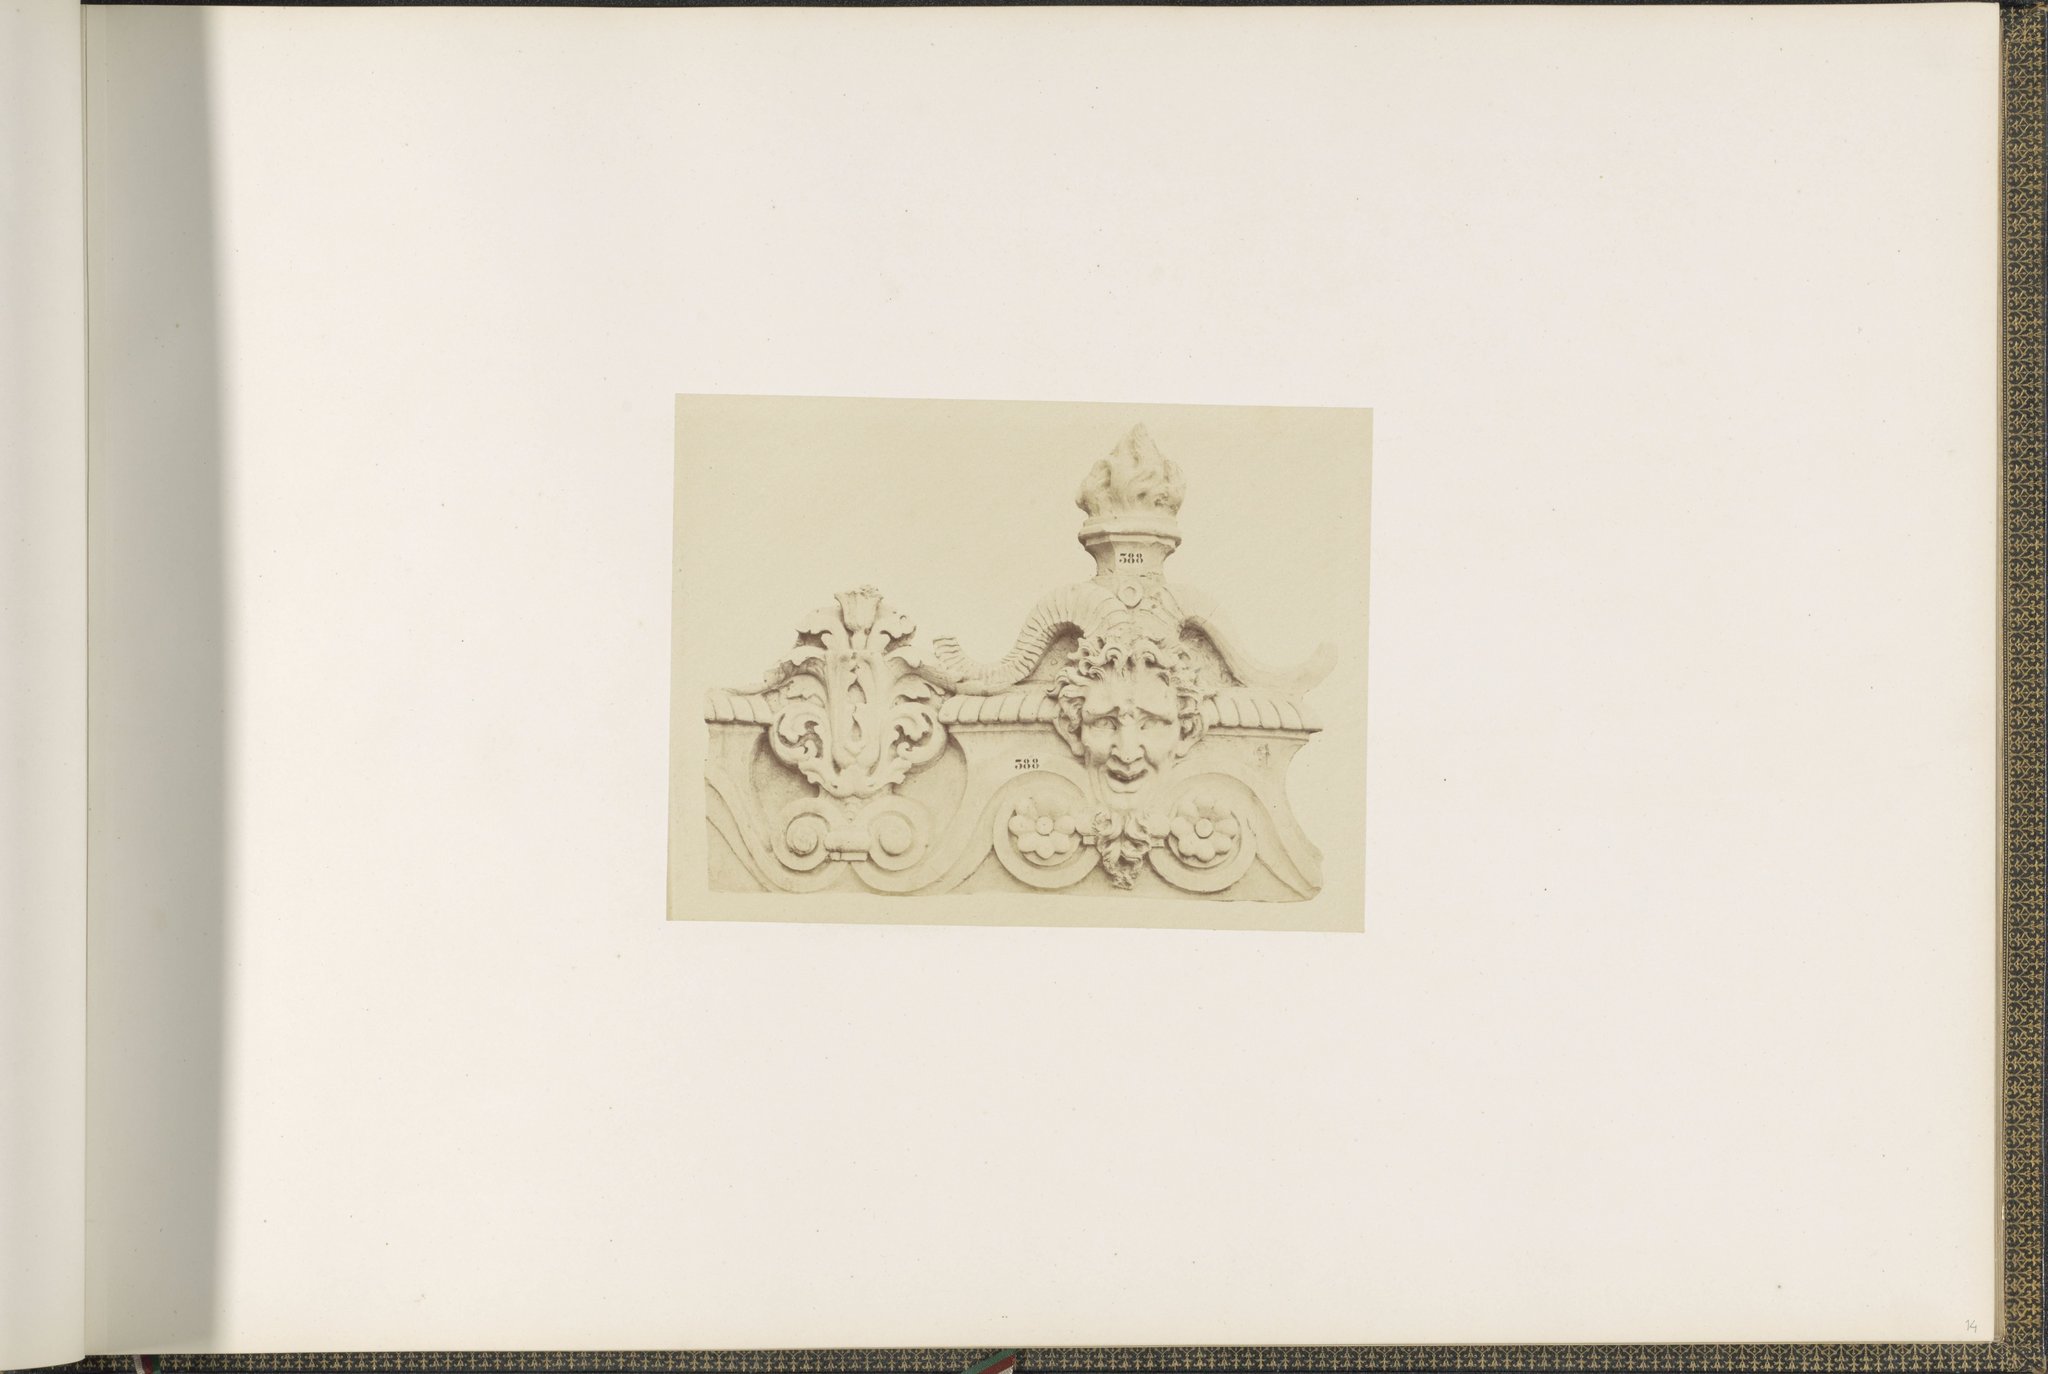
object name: album leaf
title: Detail van een gipsmodel voor de versiering van het Palais du Louvre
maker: édouard denis baldus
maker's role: fotograaf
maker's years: 1813-1889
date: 1855-1857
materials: paper, photographic support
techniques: salted paper print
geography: paris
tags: piece of sculpture, reproduction of a piece of sculpture, permanent exhibition, museum, paris, tuileries palace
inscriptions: number: ‘388’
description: Onderdeel van Réunion des Tuileries au Louvre 1852-1857, album 4.